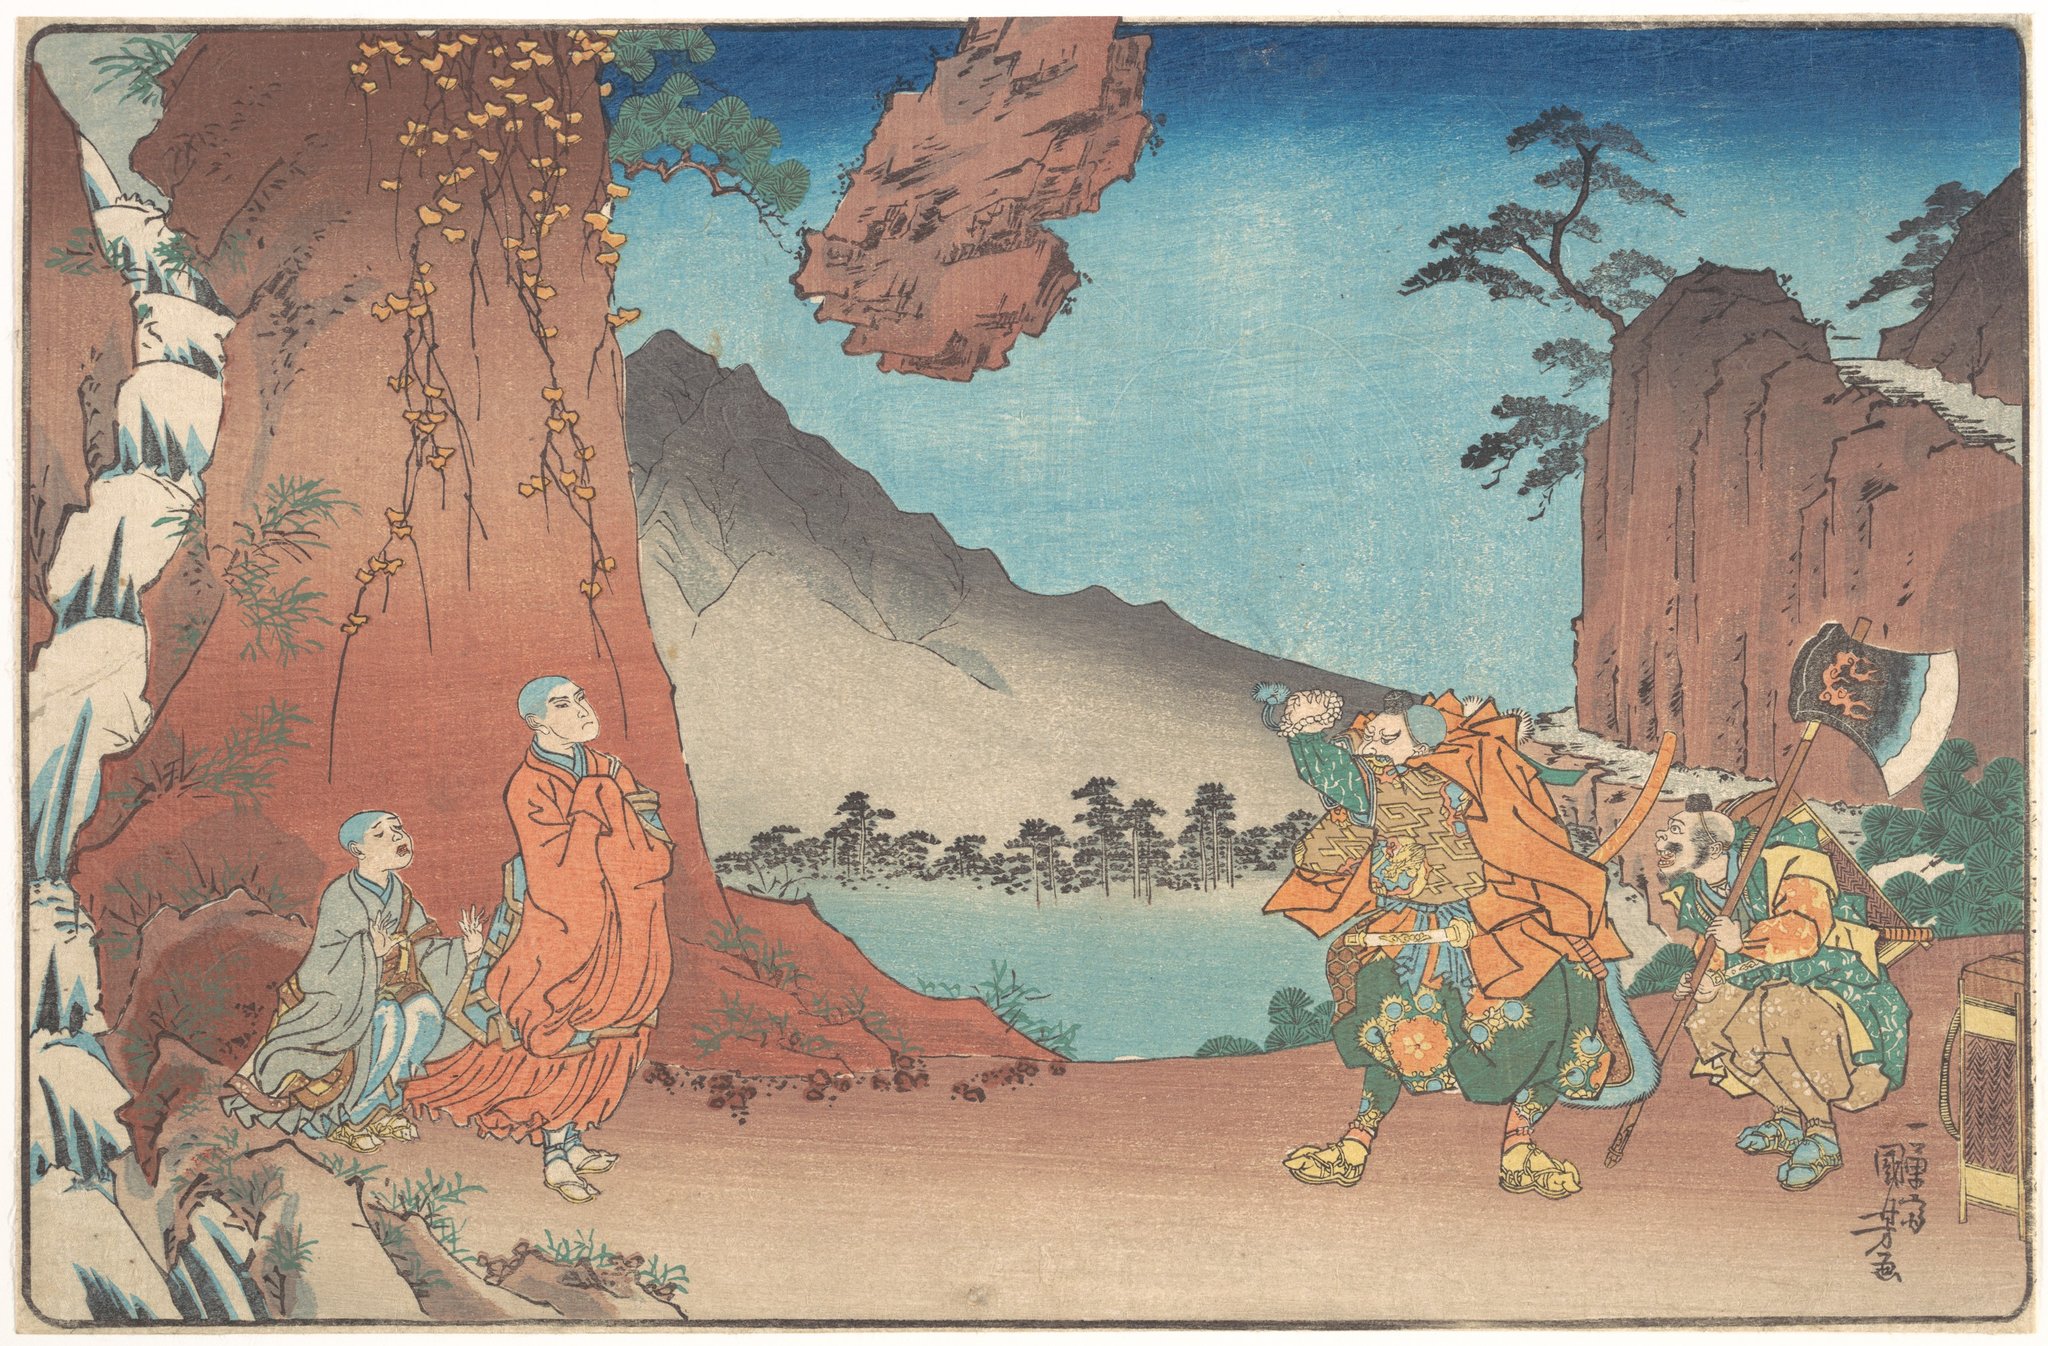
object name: print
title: Concise Illustrated Biography of Monk Nichiren: Rock Suspended by the Power of Prayer on Komuro Mountain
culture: japanese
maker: utagawa kuniyoshi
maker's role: artist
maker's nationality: japanese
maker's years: 1797-1861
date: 1835-1836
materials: ink, paper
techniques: woodblock print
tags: men,mountains,trees